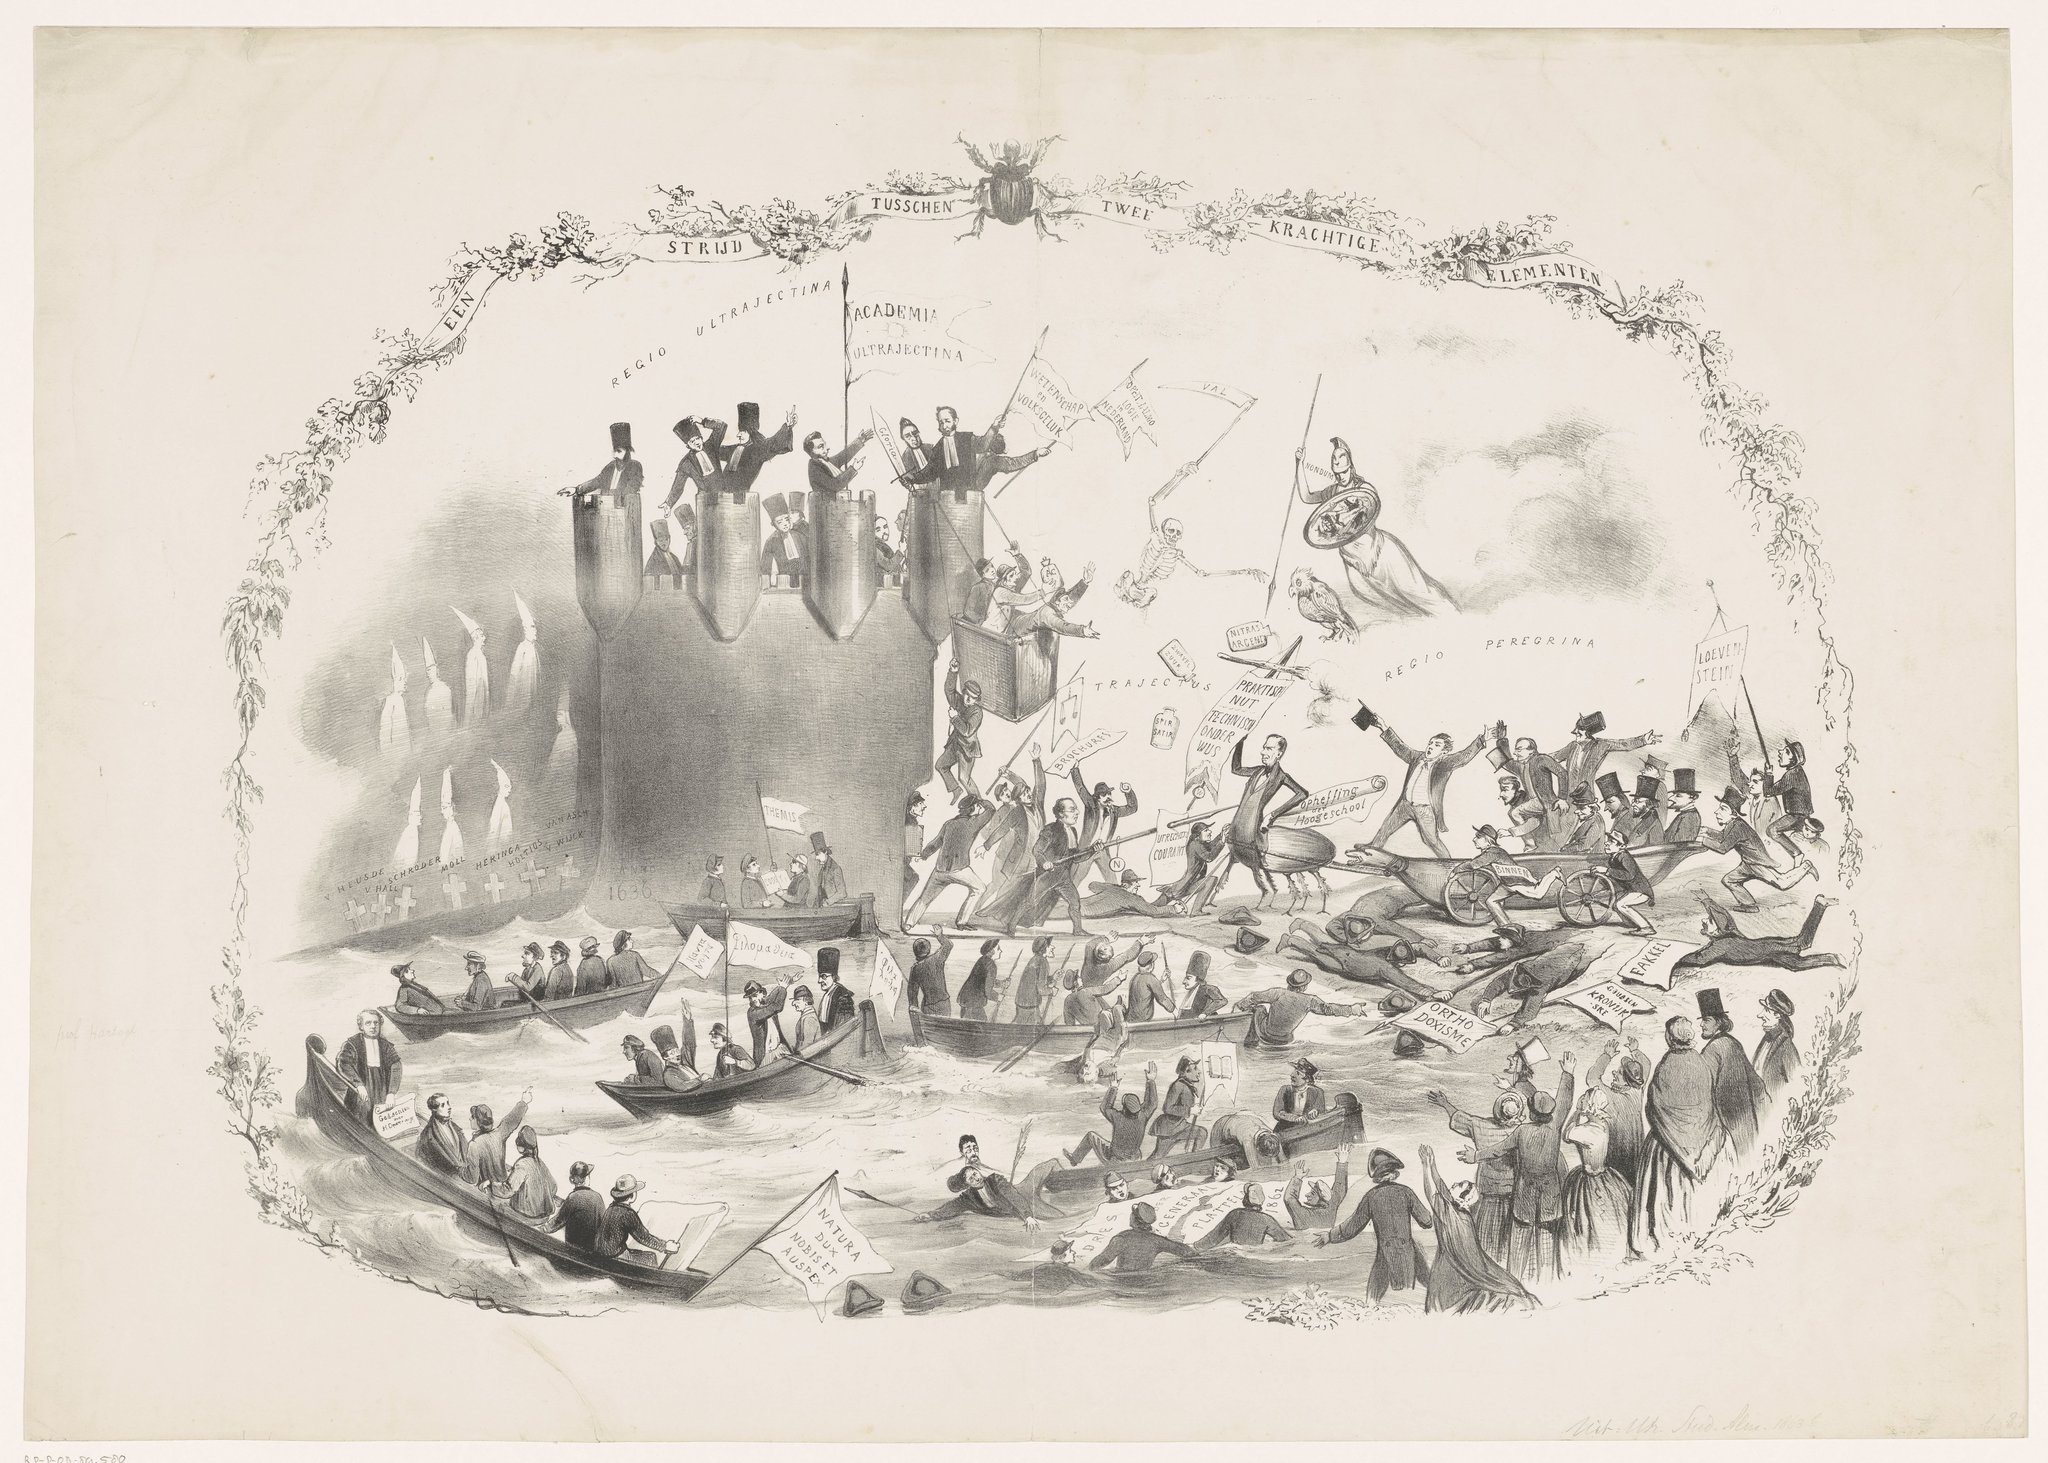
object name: cartoon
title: Een strijd tusschen twee krachtige elementen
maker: Anonymous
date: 1863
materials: paper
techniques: lithograph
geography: utrecht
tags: johan rudolf thorbecke, professor, university, siege, student life, utrecht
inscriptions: collector's mark: Lugt 2228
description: Spotprent op de plannen van Minister Thorbecke om de Utrechtse Hogeschool op te heffen, 1863. Centraal de Utrechtse Hogeschool als een burcht verdedigd door een aantal hoogleraren (Opzoomer, Miquel, Mulder etc.). Onder leiding van Prof. Vreede doet een groep studenten een uitval tegen een monster (Thorbecke). In de slotgracht een aantal boten met studenten en professoren (Harting, Hoek, Millies). Vanaf de kant ziet publiek toe. Plaat uit de studentenalmanak van de Utrechtse Hogeschool van 1863.